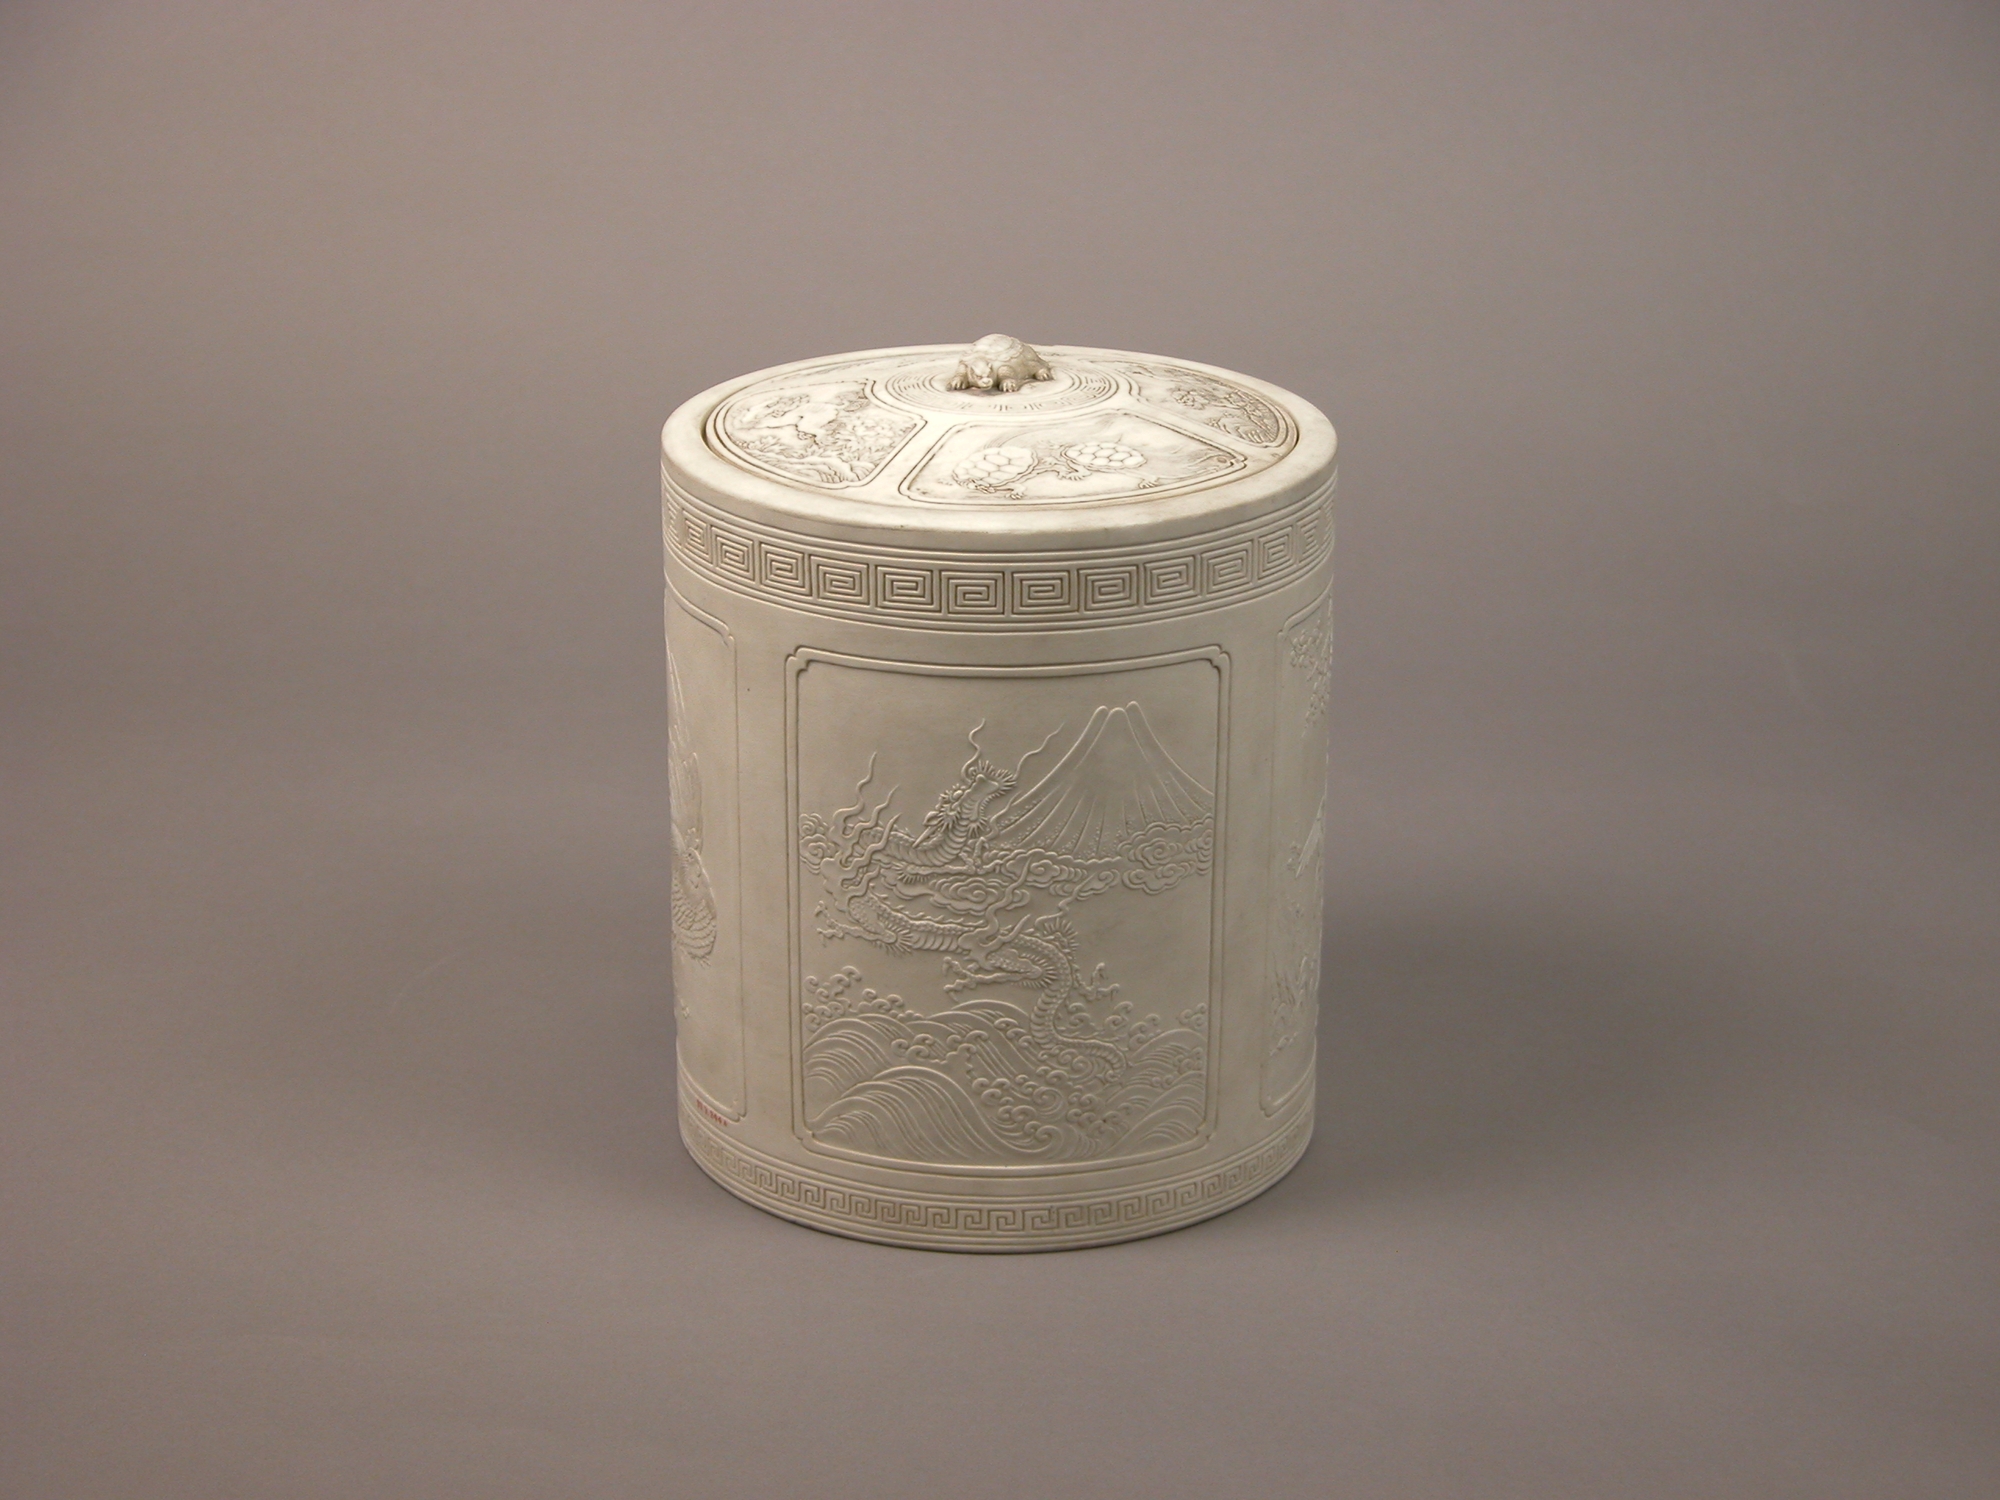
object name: water jar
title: Water Jar with Dragon, Mount Fuji, Kirin, Cockerels, and Auspicious Motifs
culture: japanese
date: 1851-1900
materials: biscuit, earthenware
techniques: relief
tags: dragons,roosters,mountains,trees